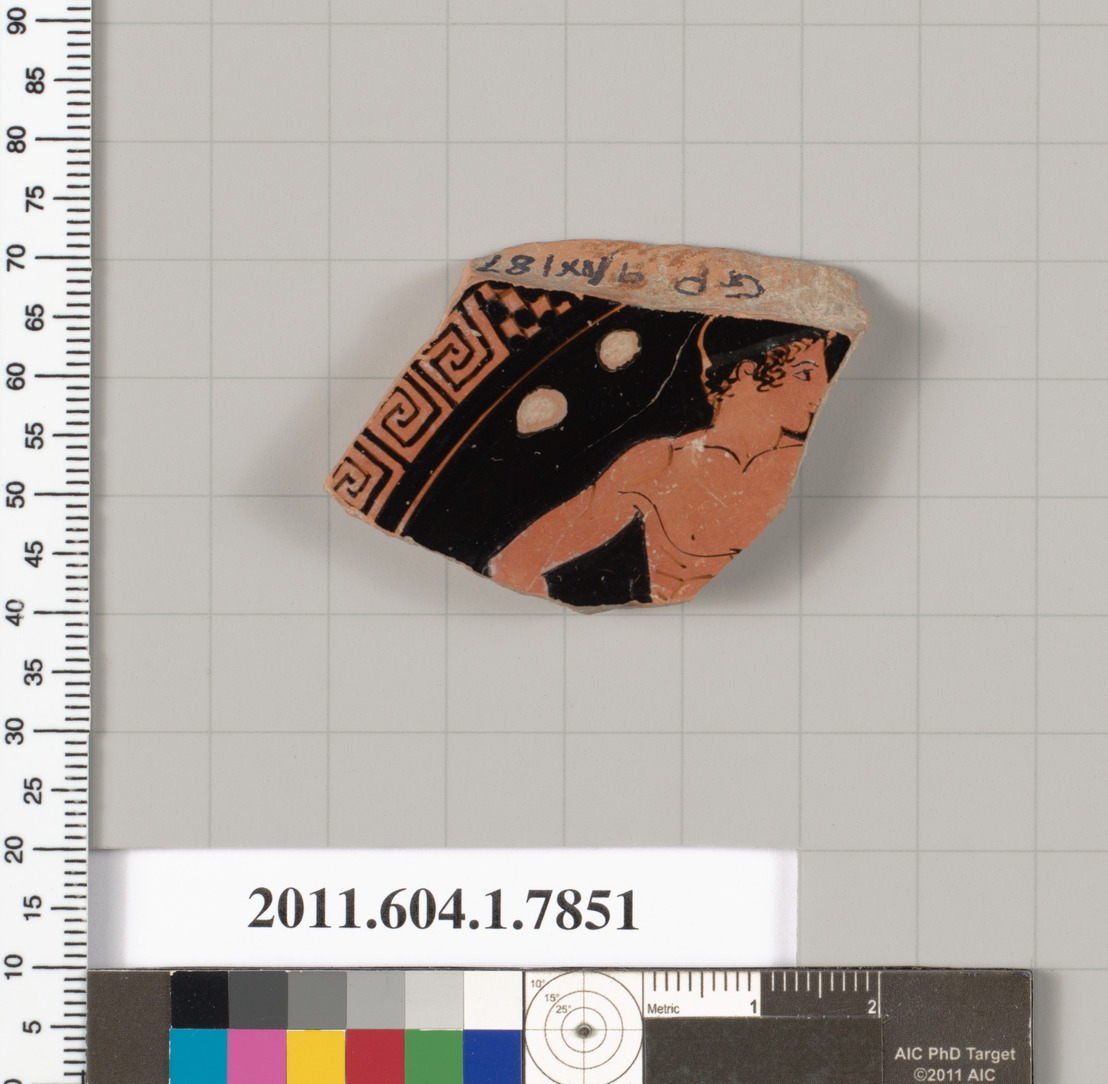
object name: kylix fragment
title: Terracotta fragment of a kylix (drinking cup)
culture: greek, attic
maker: eretria painter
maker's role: artist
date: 450-426 BCE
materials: terracotta